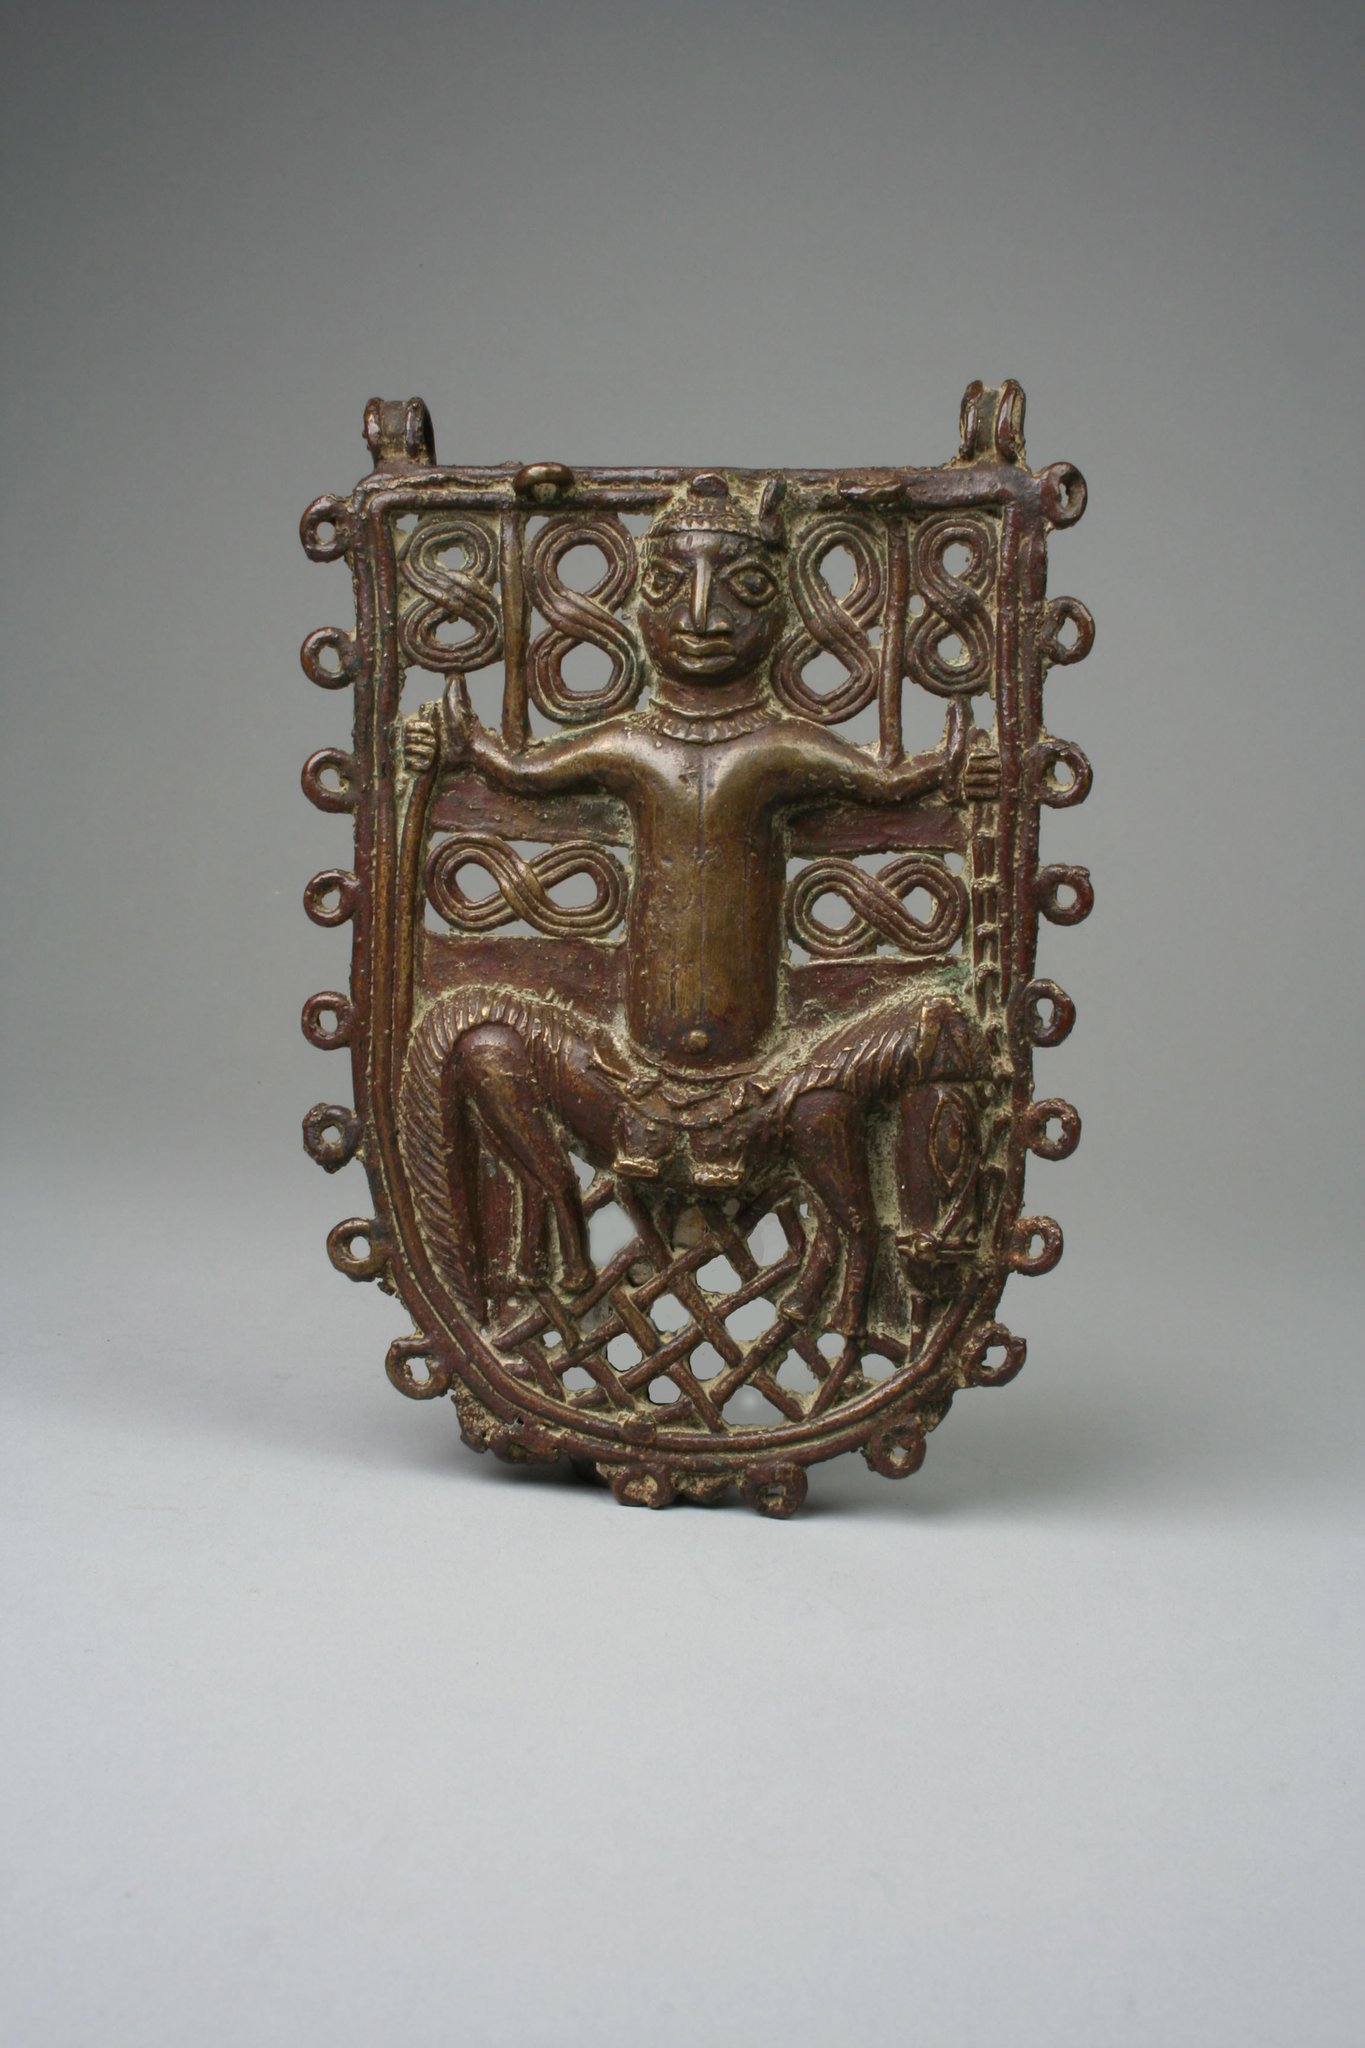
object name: pendant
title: Waist Pendant: Equestrain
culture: edo period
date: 1501-1900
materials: brass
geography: nigeria